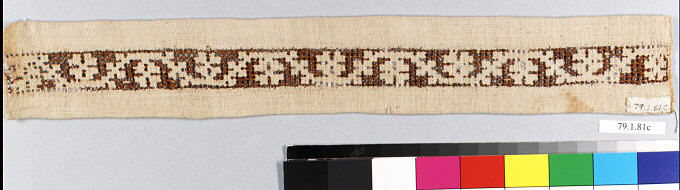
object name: strip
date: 1501-1600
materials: linen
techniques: embroidery